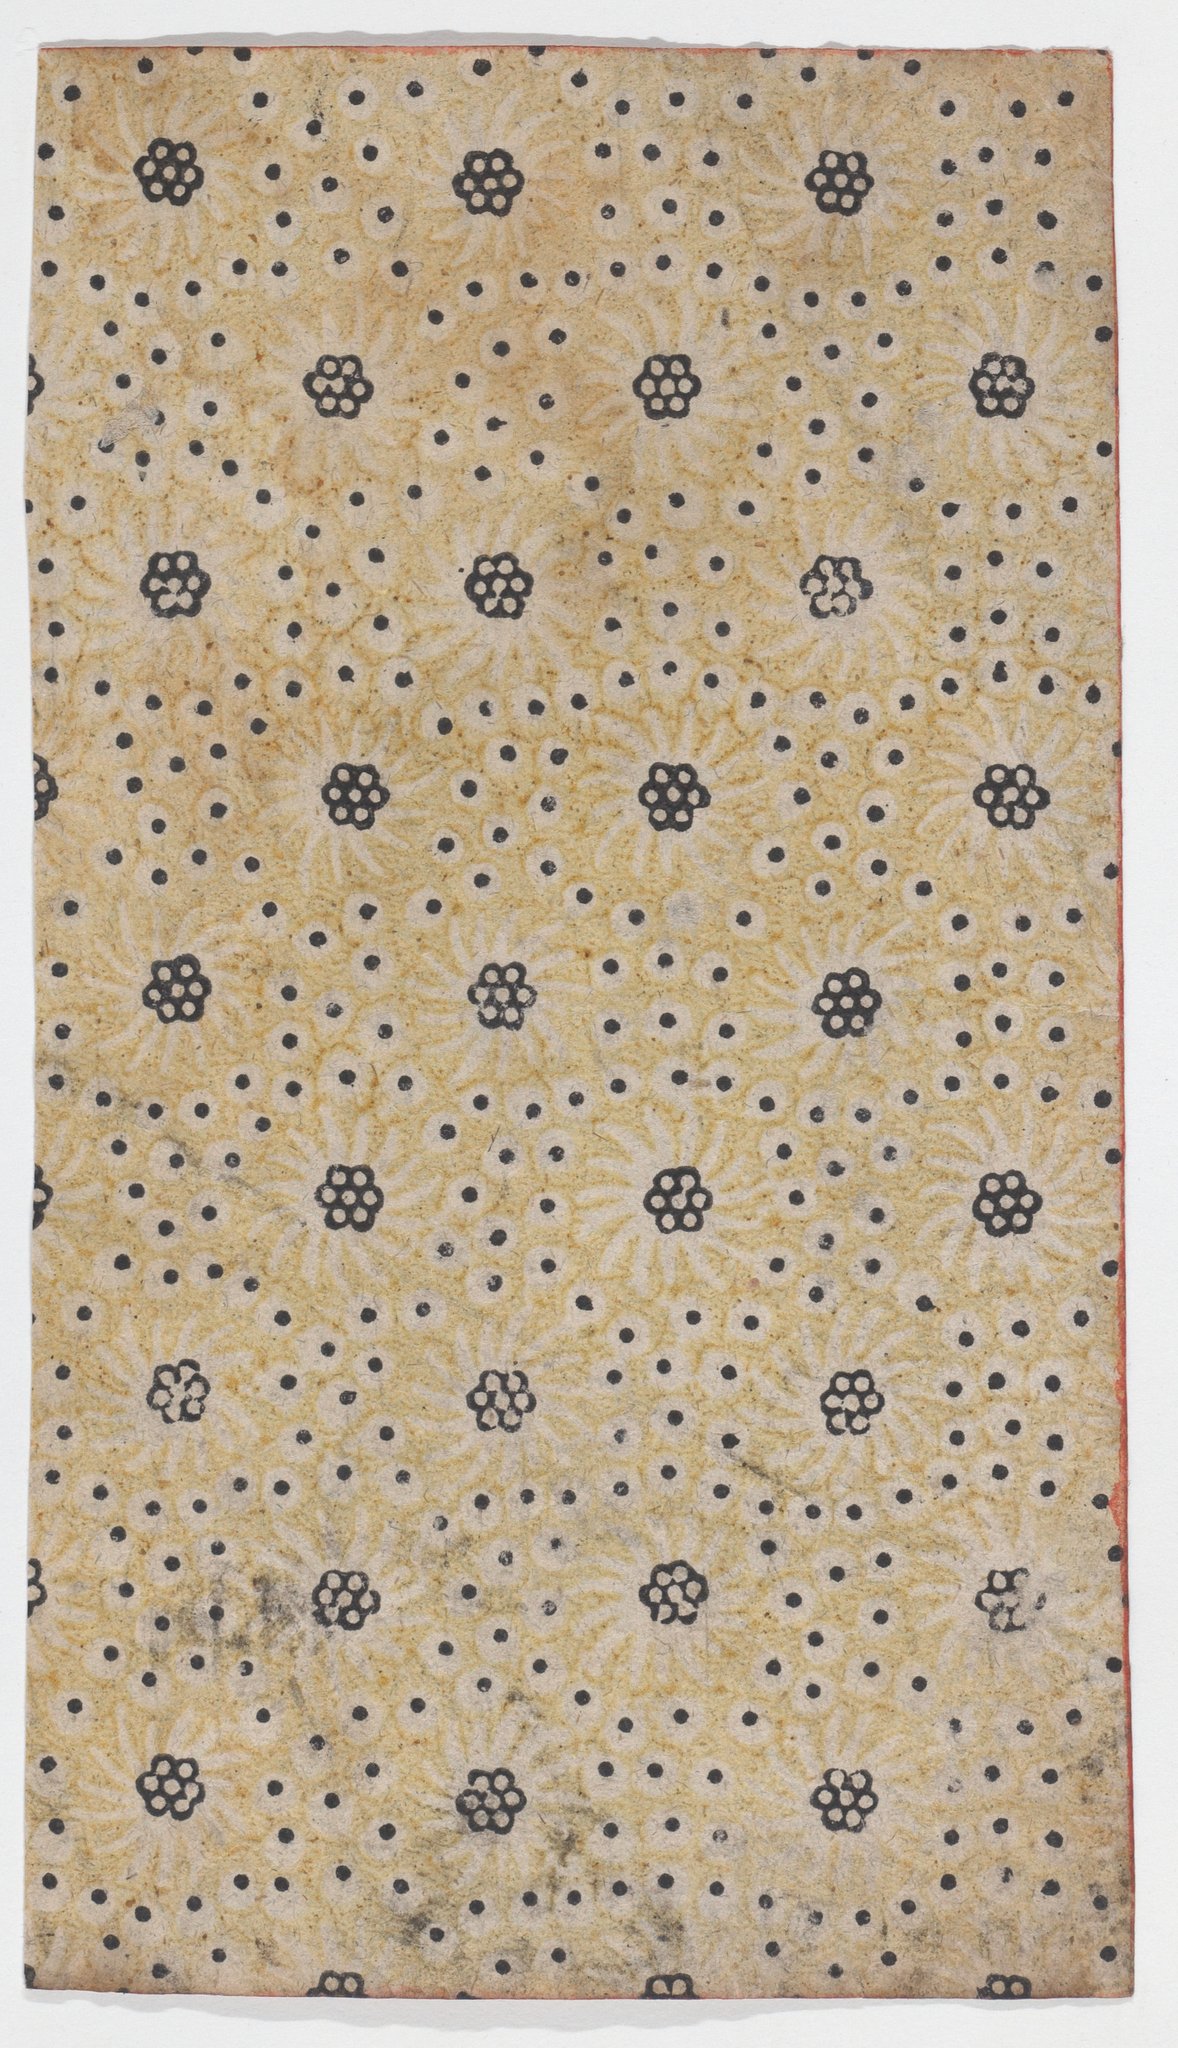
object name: print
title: Sheet with overall pattern of flowers and dots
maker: Anonymous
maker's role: artist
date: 1801-1900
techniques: relief print